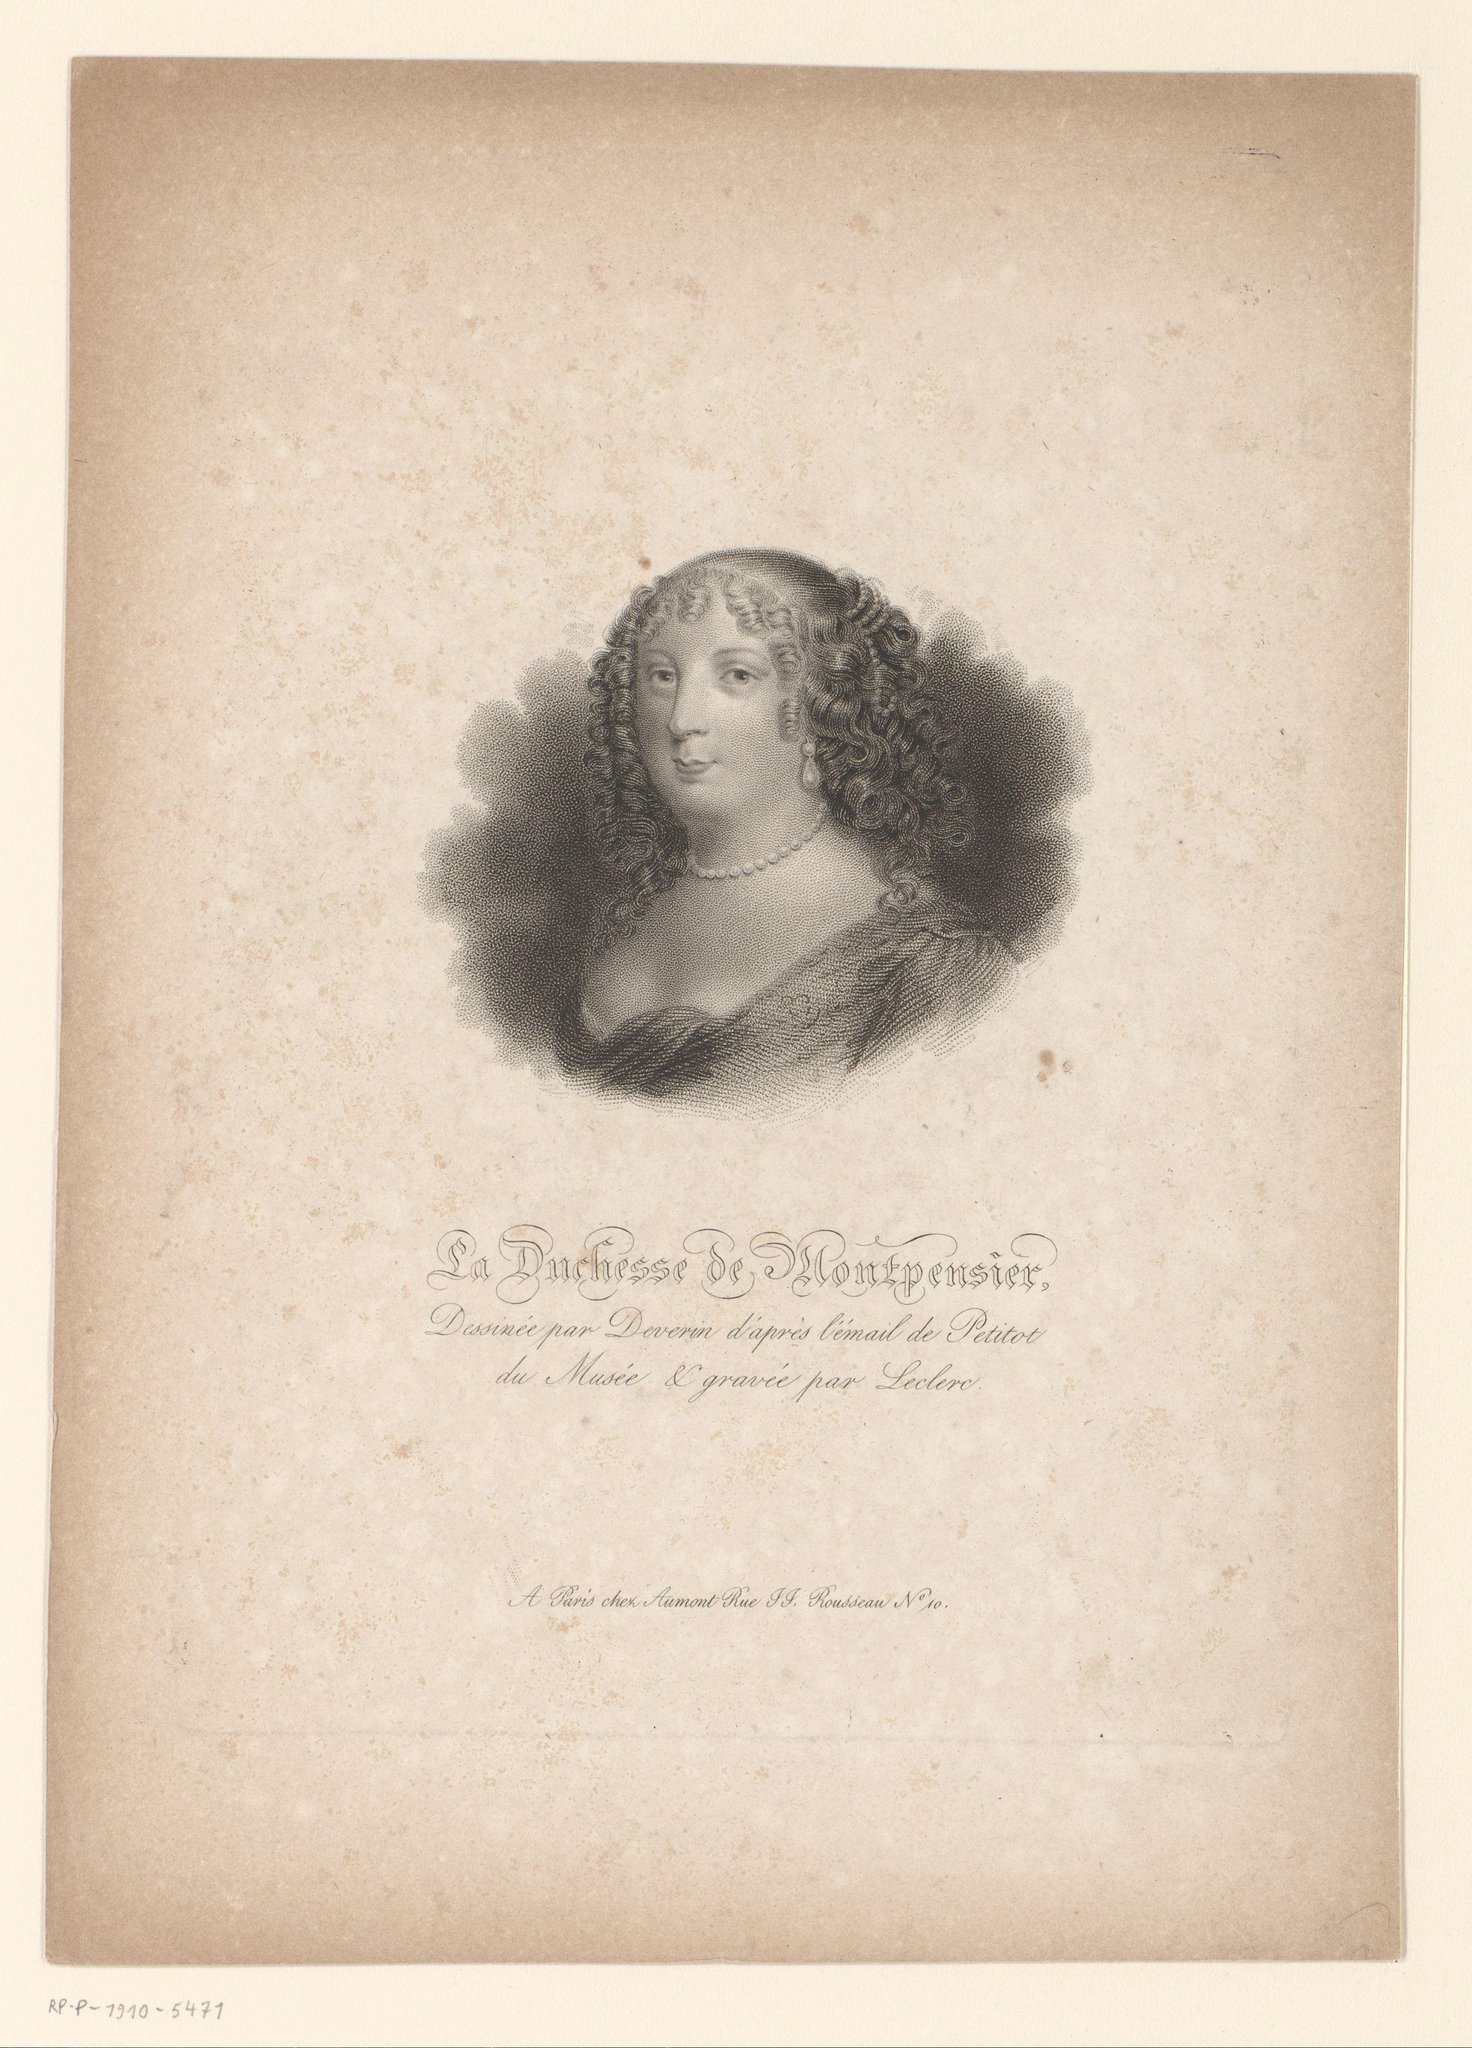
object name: print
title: La duchesse de Montpensier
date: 1830-1850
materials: paper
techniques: engraving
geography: france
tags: paris, anne marie louise d' orléans (hertogin van montpensier), historical persons - bb - woman, nobility and patriciate; chivalry, knighthood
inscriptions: collector's mark: Lugt 2228